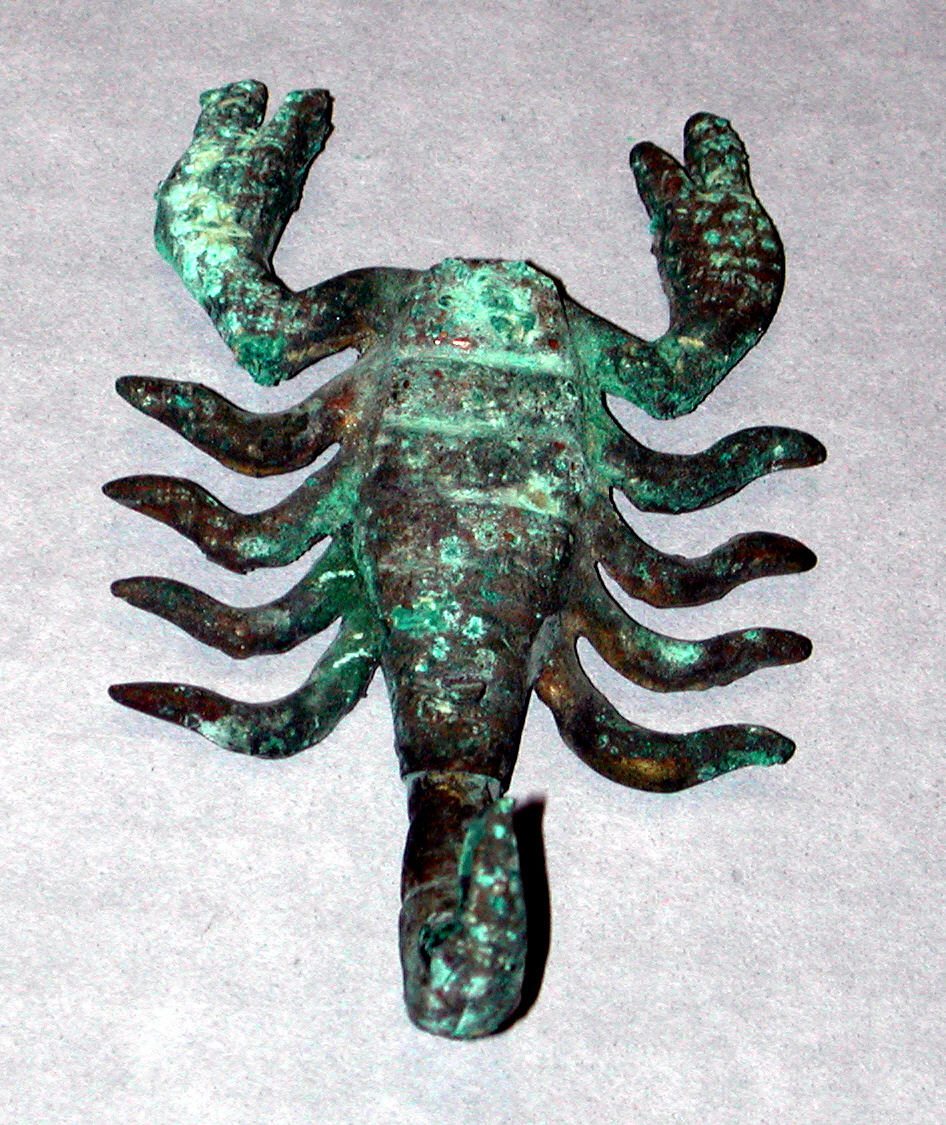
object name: ornament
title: Scorpion Ornament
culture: moche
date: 501-700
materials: gilt copper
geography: peru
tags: scorpions